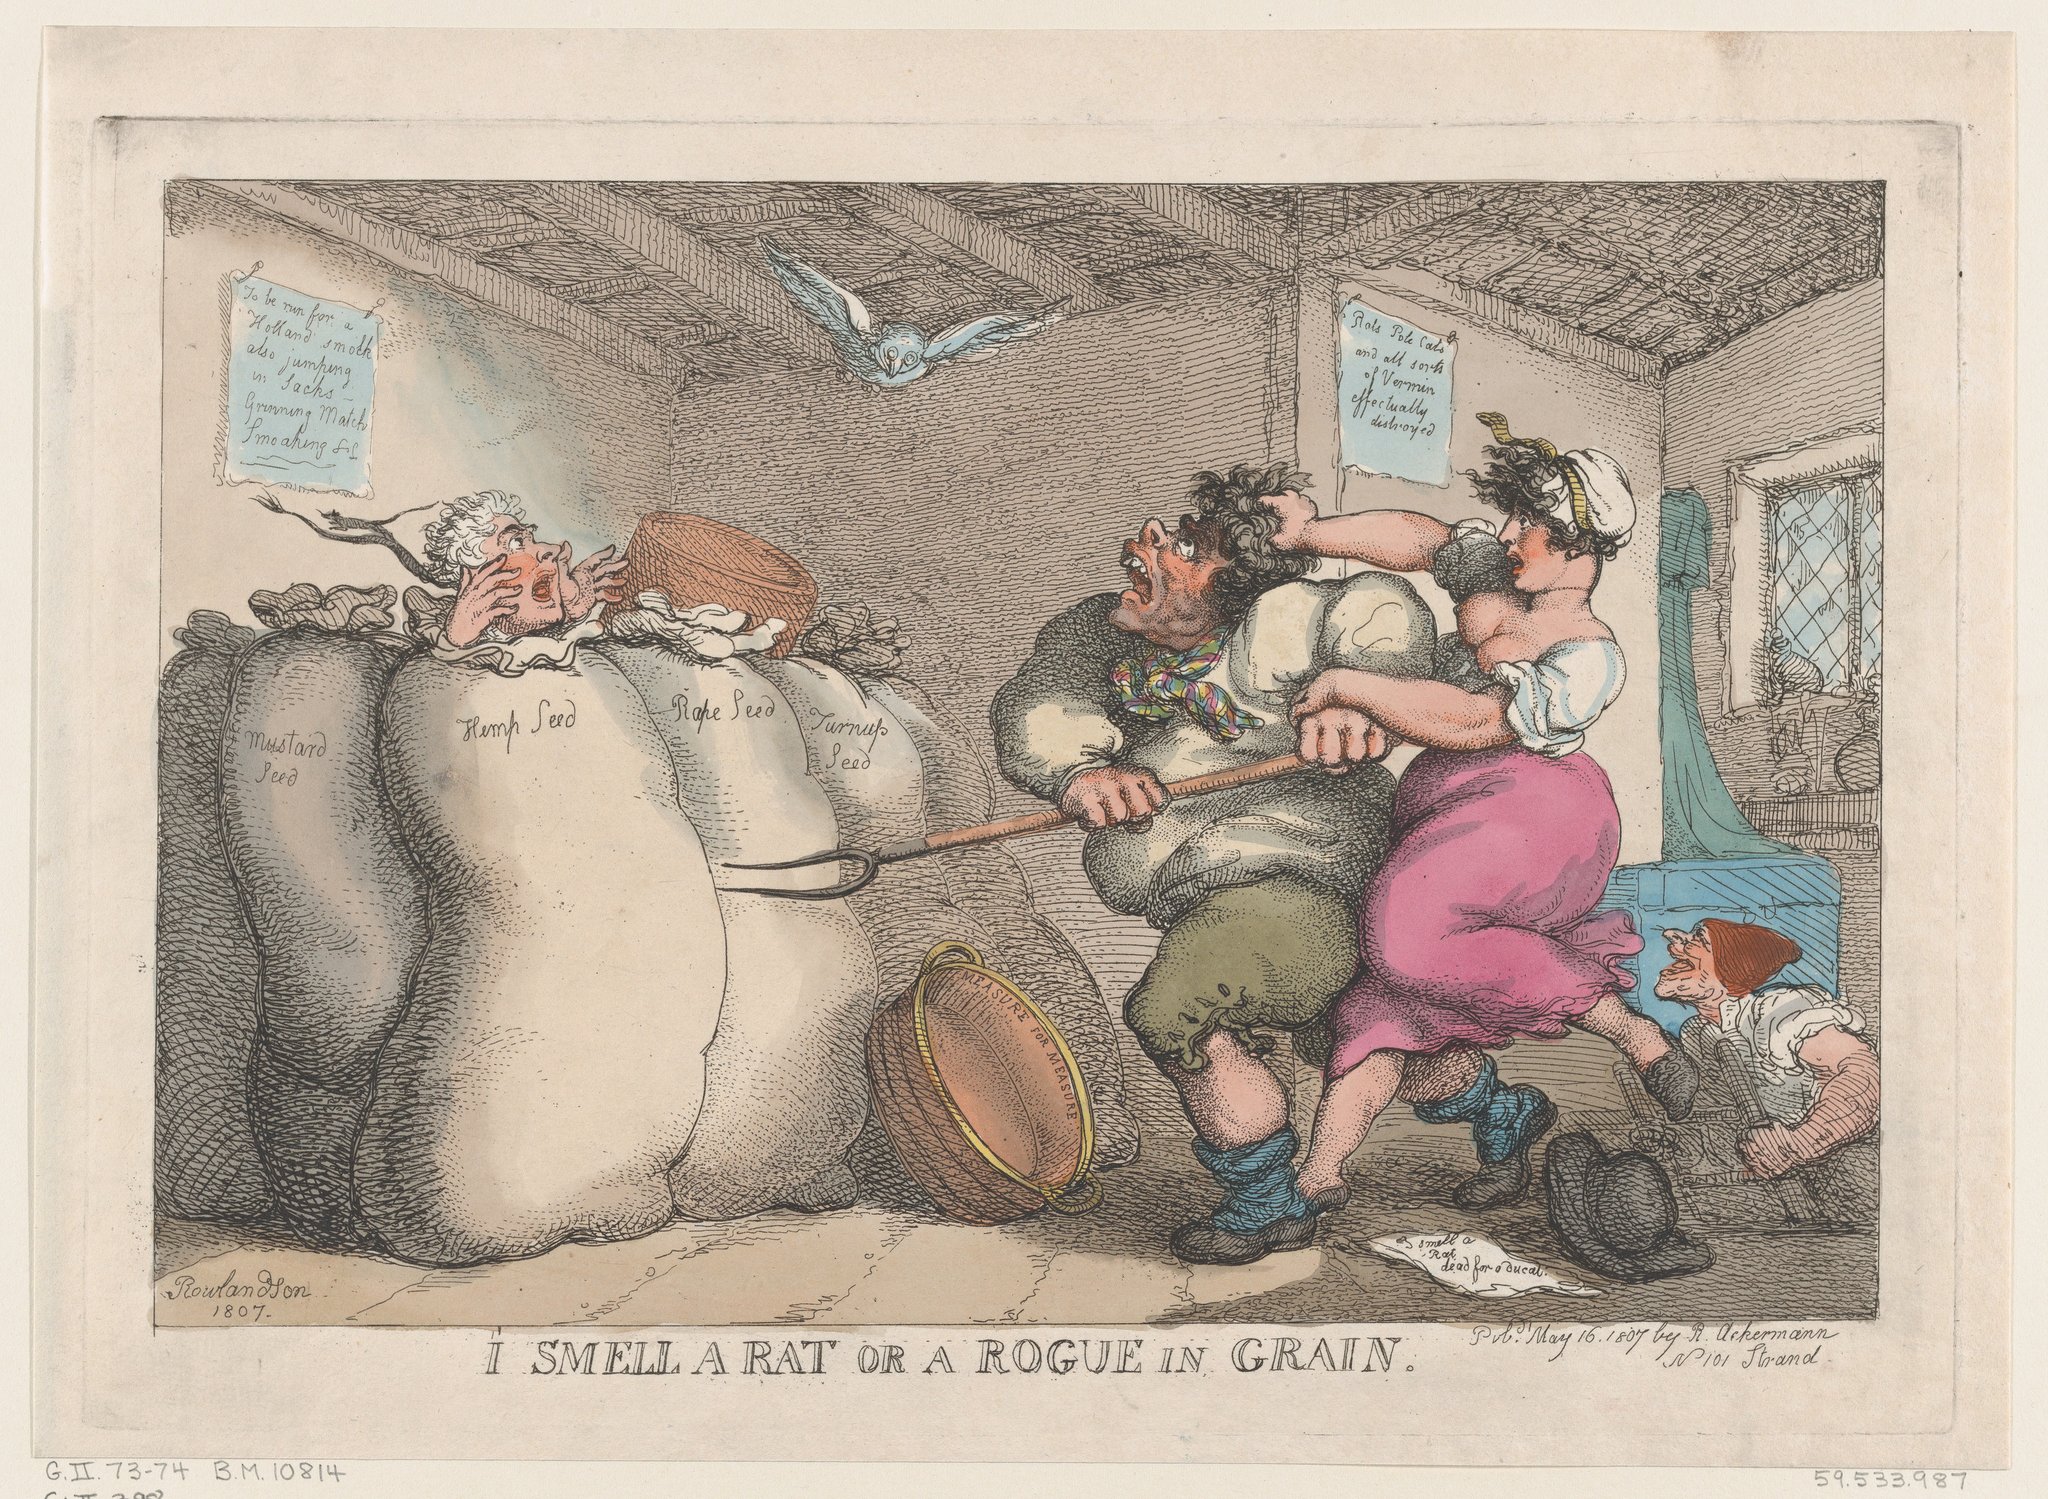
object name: print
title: I Smell a Rat or a Rogue in Grain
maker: thomas rowlandson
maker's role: artist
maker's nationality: british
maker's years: 1757-1827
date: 1807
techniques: etching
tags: satire,men,women